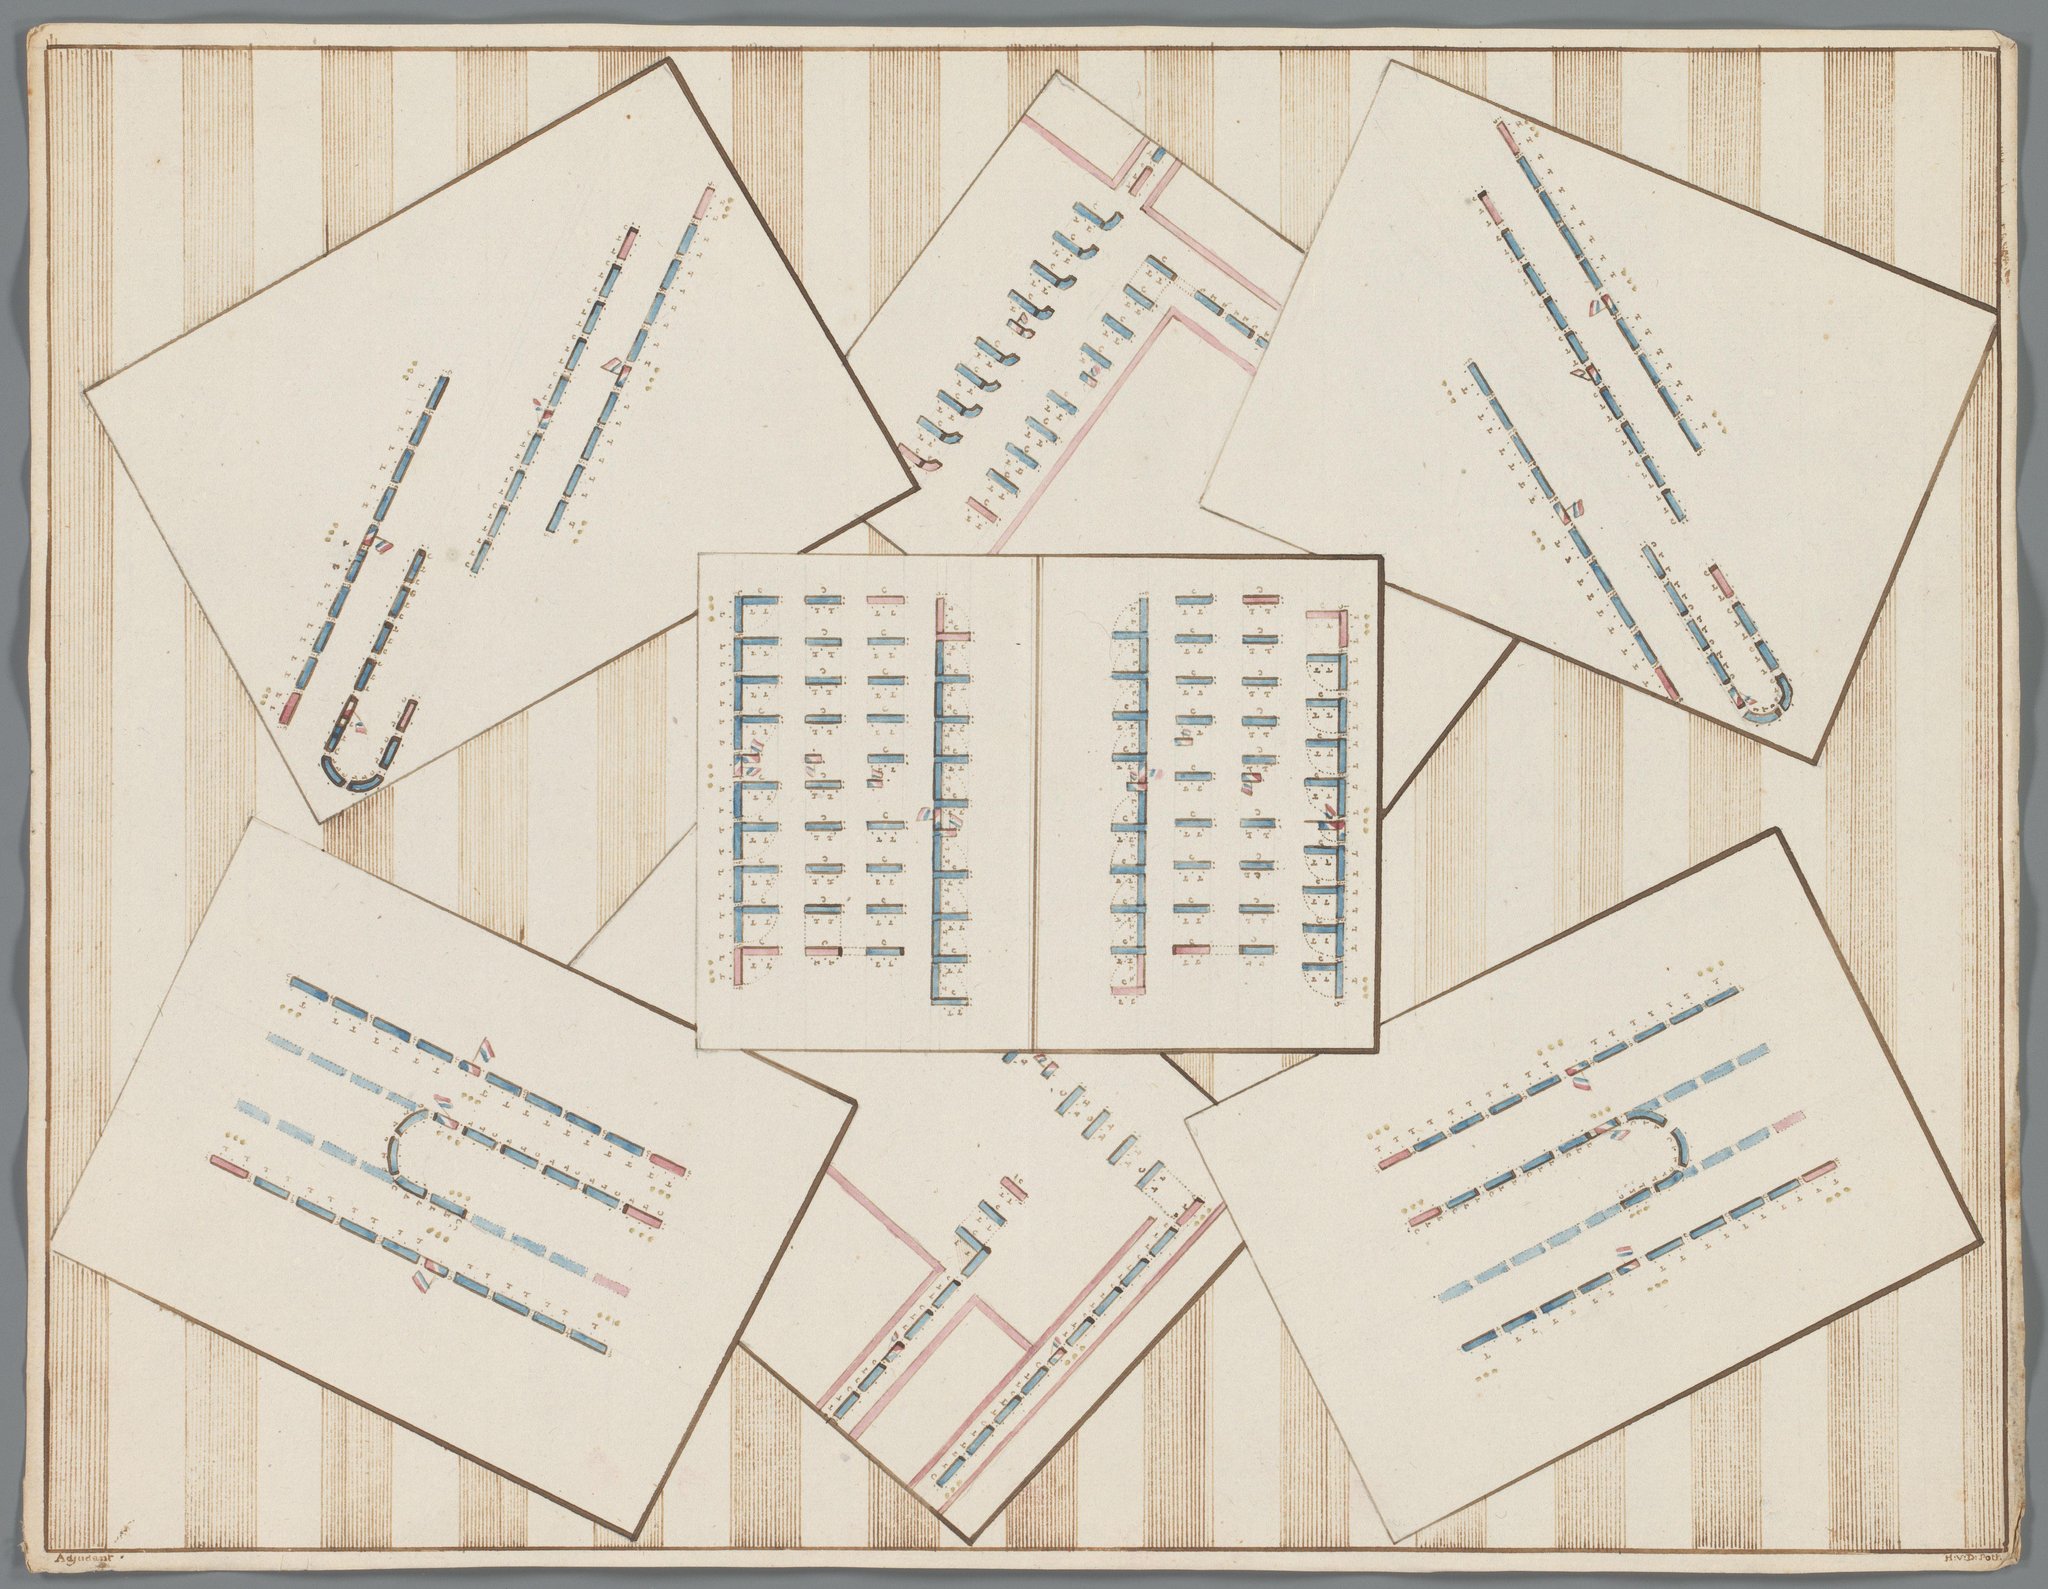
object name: drawing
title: Manoeuvres van de compagnieën, ca. 1799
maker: hendrik van der poth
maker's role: draughtsman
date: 1799-1803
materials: paper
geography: netherlands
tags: manoeuvre ~ military training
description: Blad met zeven kaartjes van verschillende manoeuvres van de zeven compagnieën van het Bataafse bataljon. Ten tijde van de Brits-Russische expeditie in 1799. Onderdeel van een groep van zeventien getekende kaarten.